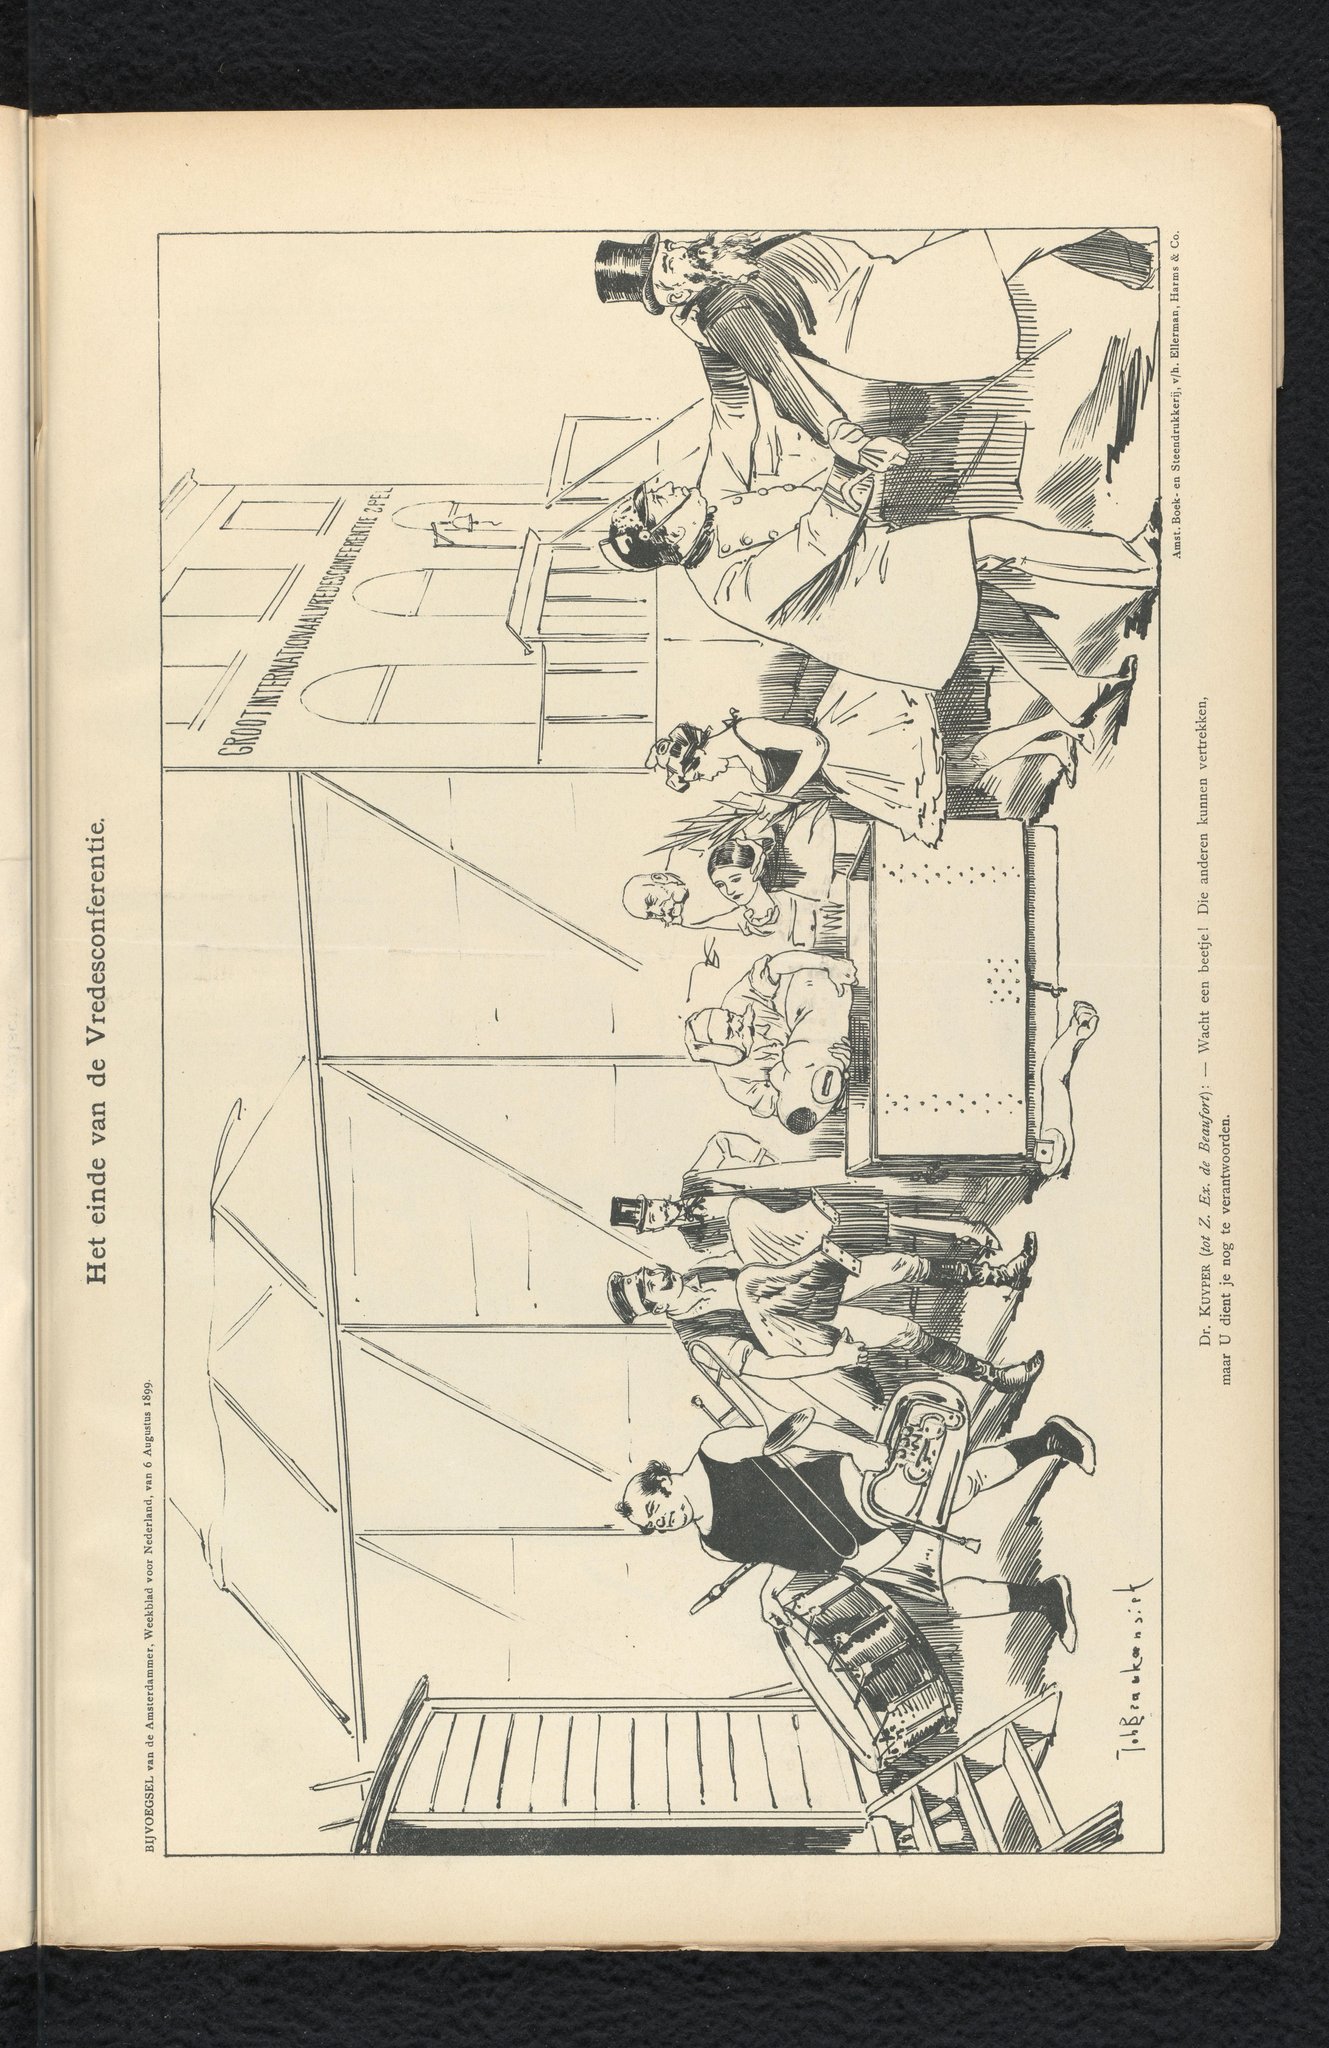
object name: cartoon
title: Het einde van de Vredesconferentie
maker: johan braakensiek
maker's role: draughtsman, print maker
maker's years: 1858-1940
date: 1899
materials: paper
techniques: lithograph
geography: amsterdam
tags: abraham kuyper, the hague, personifications of countries, nations, states, districts, etc., symbols, allegories of peace, 'pax'; 'pace' (ripa), circus, arrest (of criminal), political caricatures and satires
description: Na afloop van de Haagse vredesconferentie wordt alles, als een rondtrekkend circus, afgebroken en ingepakt. De onderdelen van de vredesengel worden in een kist ingepakt. Sterke man Kuyper, links met muziekinstrumenten, laat minister De Beaufort arresteren omdat hij zich moet verantwoorden.